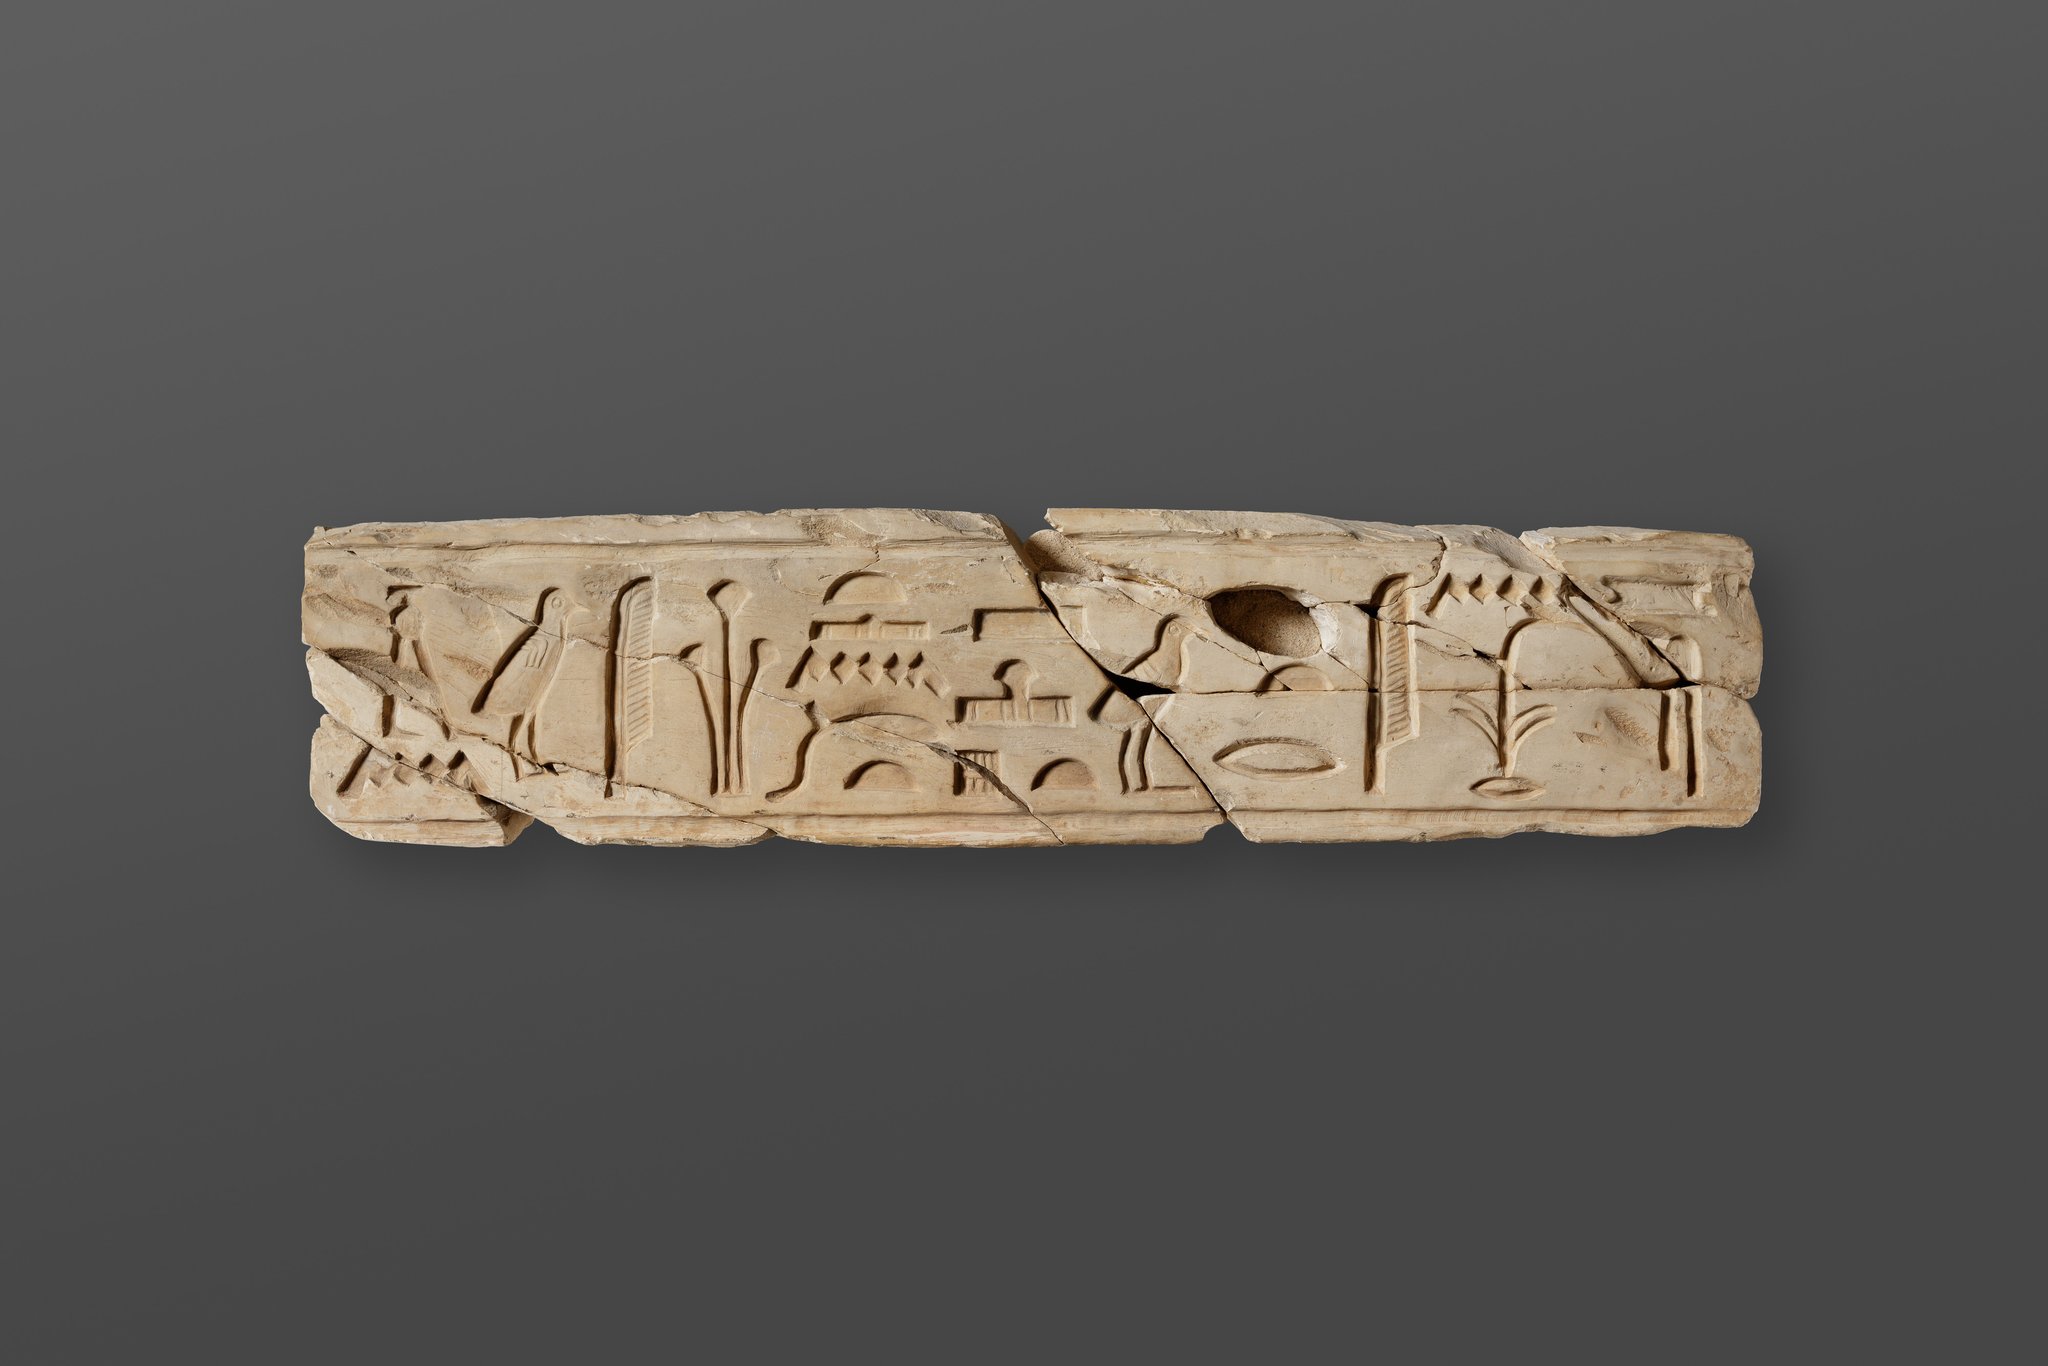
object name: relief fragment, tomb of mereri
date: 2100-2030 BCE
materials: limestone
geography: egypt